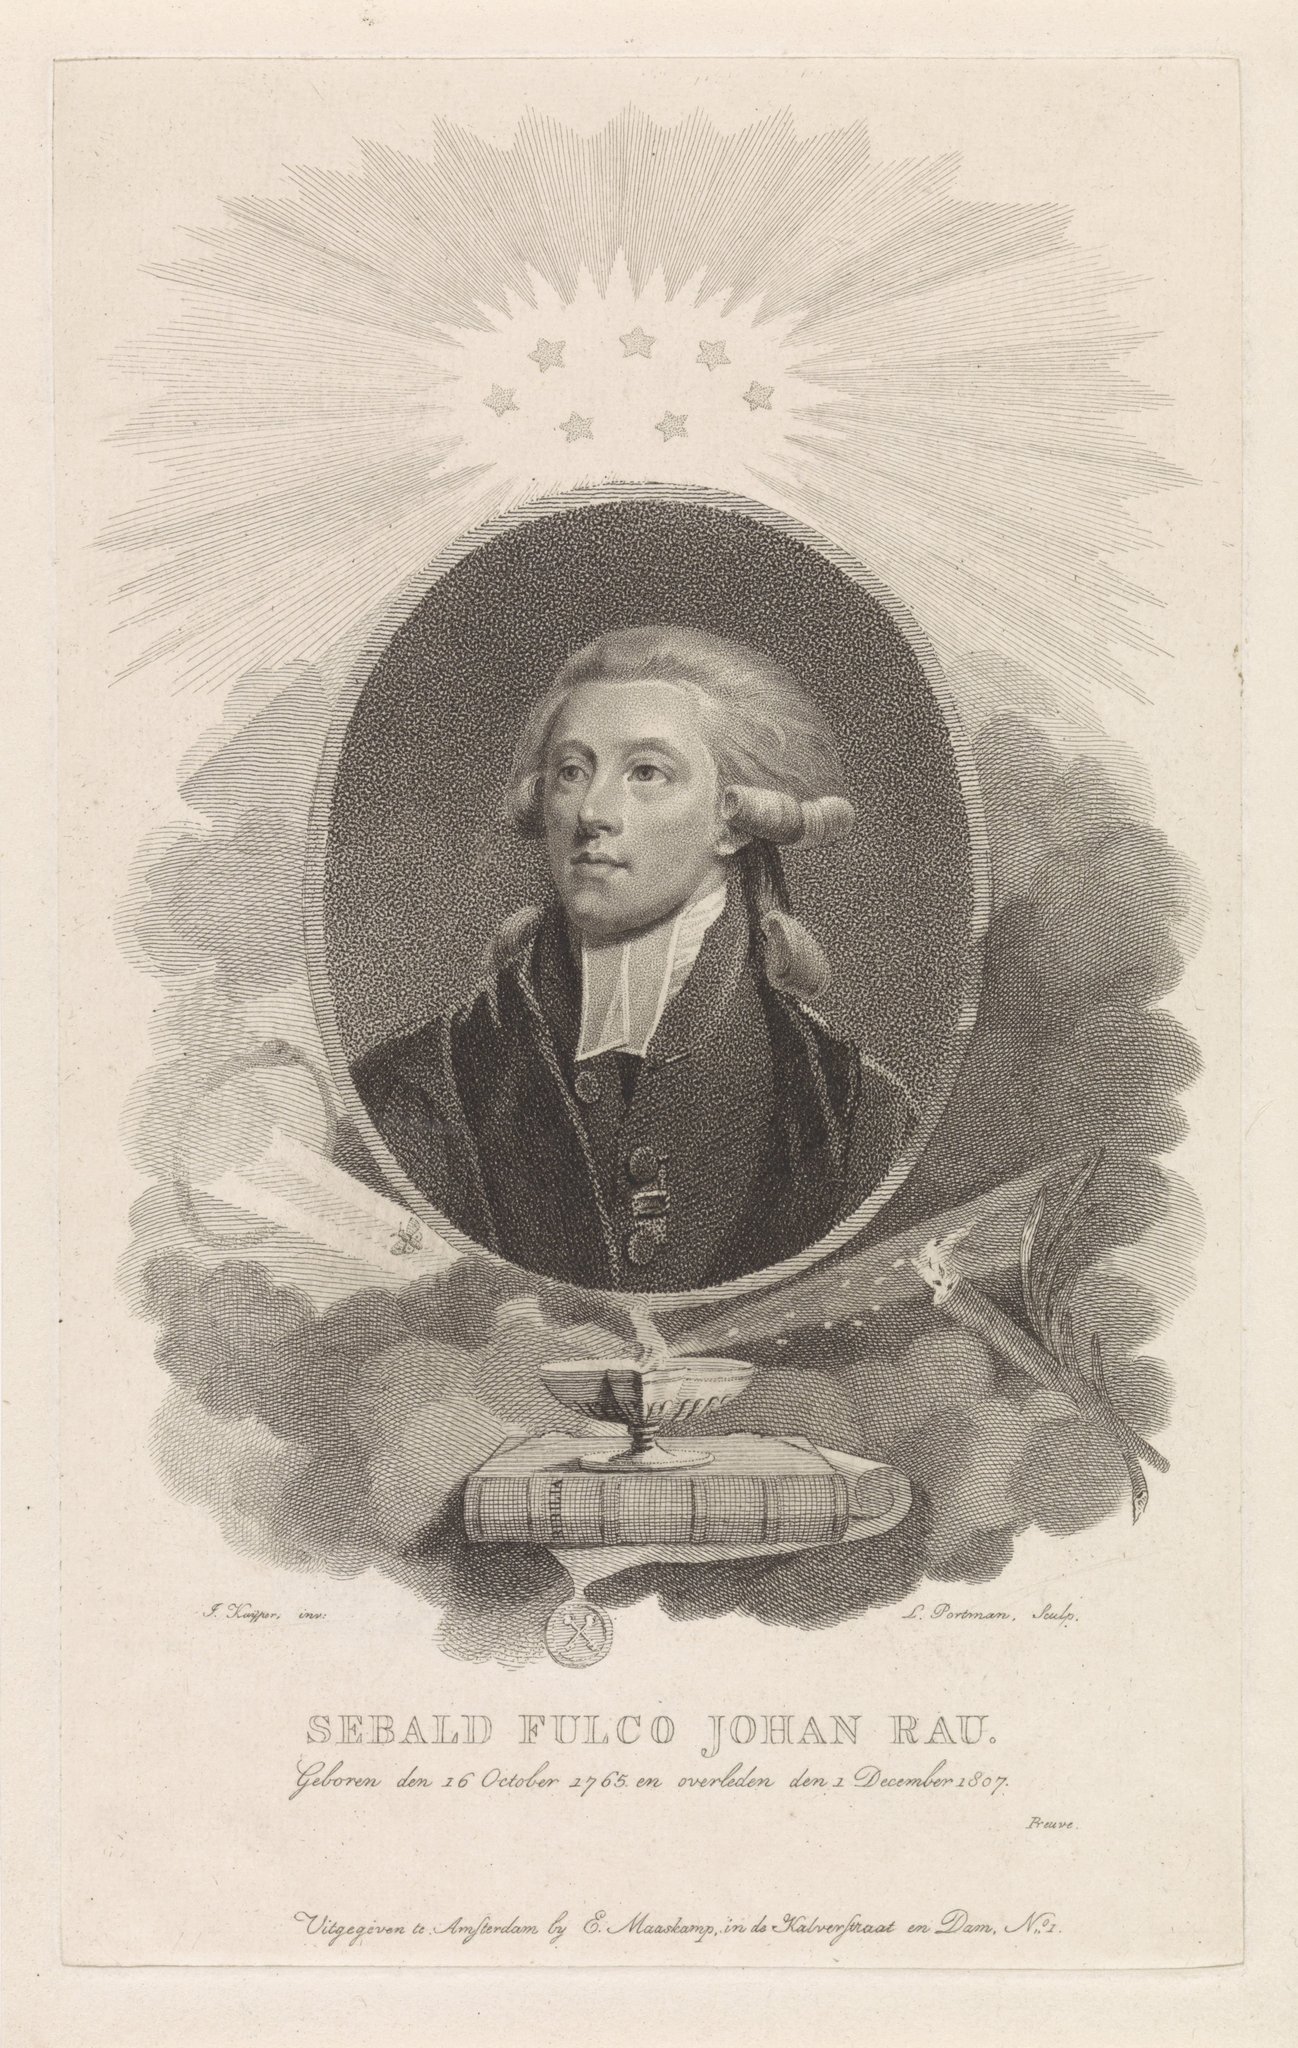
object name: print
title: Allegorisch portret van de hoogleraar Sebald Fulco Johan Rau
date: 1807-1828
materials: paper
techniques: etching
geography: amsterdam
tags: leiden, truth; 'verità' (ripa) (+ symbolical representation of concept), torch, light, insects: butterfly (+ animals used symbolically), honour, glory; 'ampiezza della gloria', 'gloria', 'gloria de prencipi', 'gloria & honore', 'honore', 'sublimatà della gloria' (ripa) (+ symbolical representation of concept), oil-lamp, serpent ouroboros, darkness, the bible as a book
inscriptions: collector's mark: Lugt 2228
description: Portret van Sebald Fulco Johan Rau. Onder zijn portret een brief, de bijbel en een lamp. Links in het licht een vlinder die naar de slang vliegt, een verwijzing naar de onsterfelijkheid van de ziel van de geportretteerde. Rechts in het duister een fakkel en een palmtak, symbool van de waarheid. Het portret is bekroond met een krans van sterren, als symbool voor eeuwige Heerlijkheid.